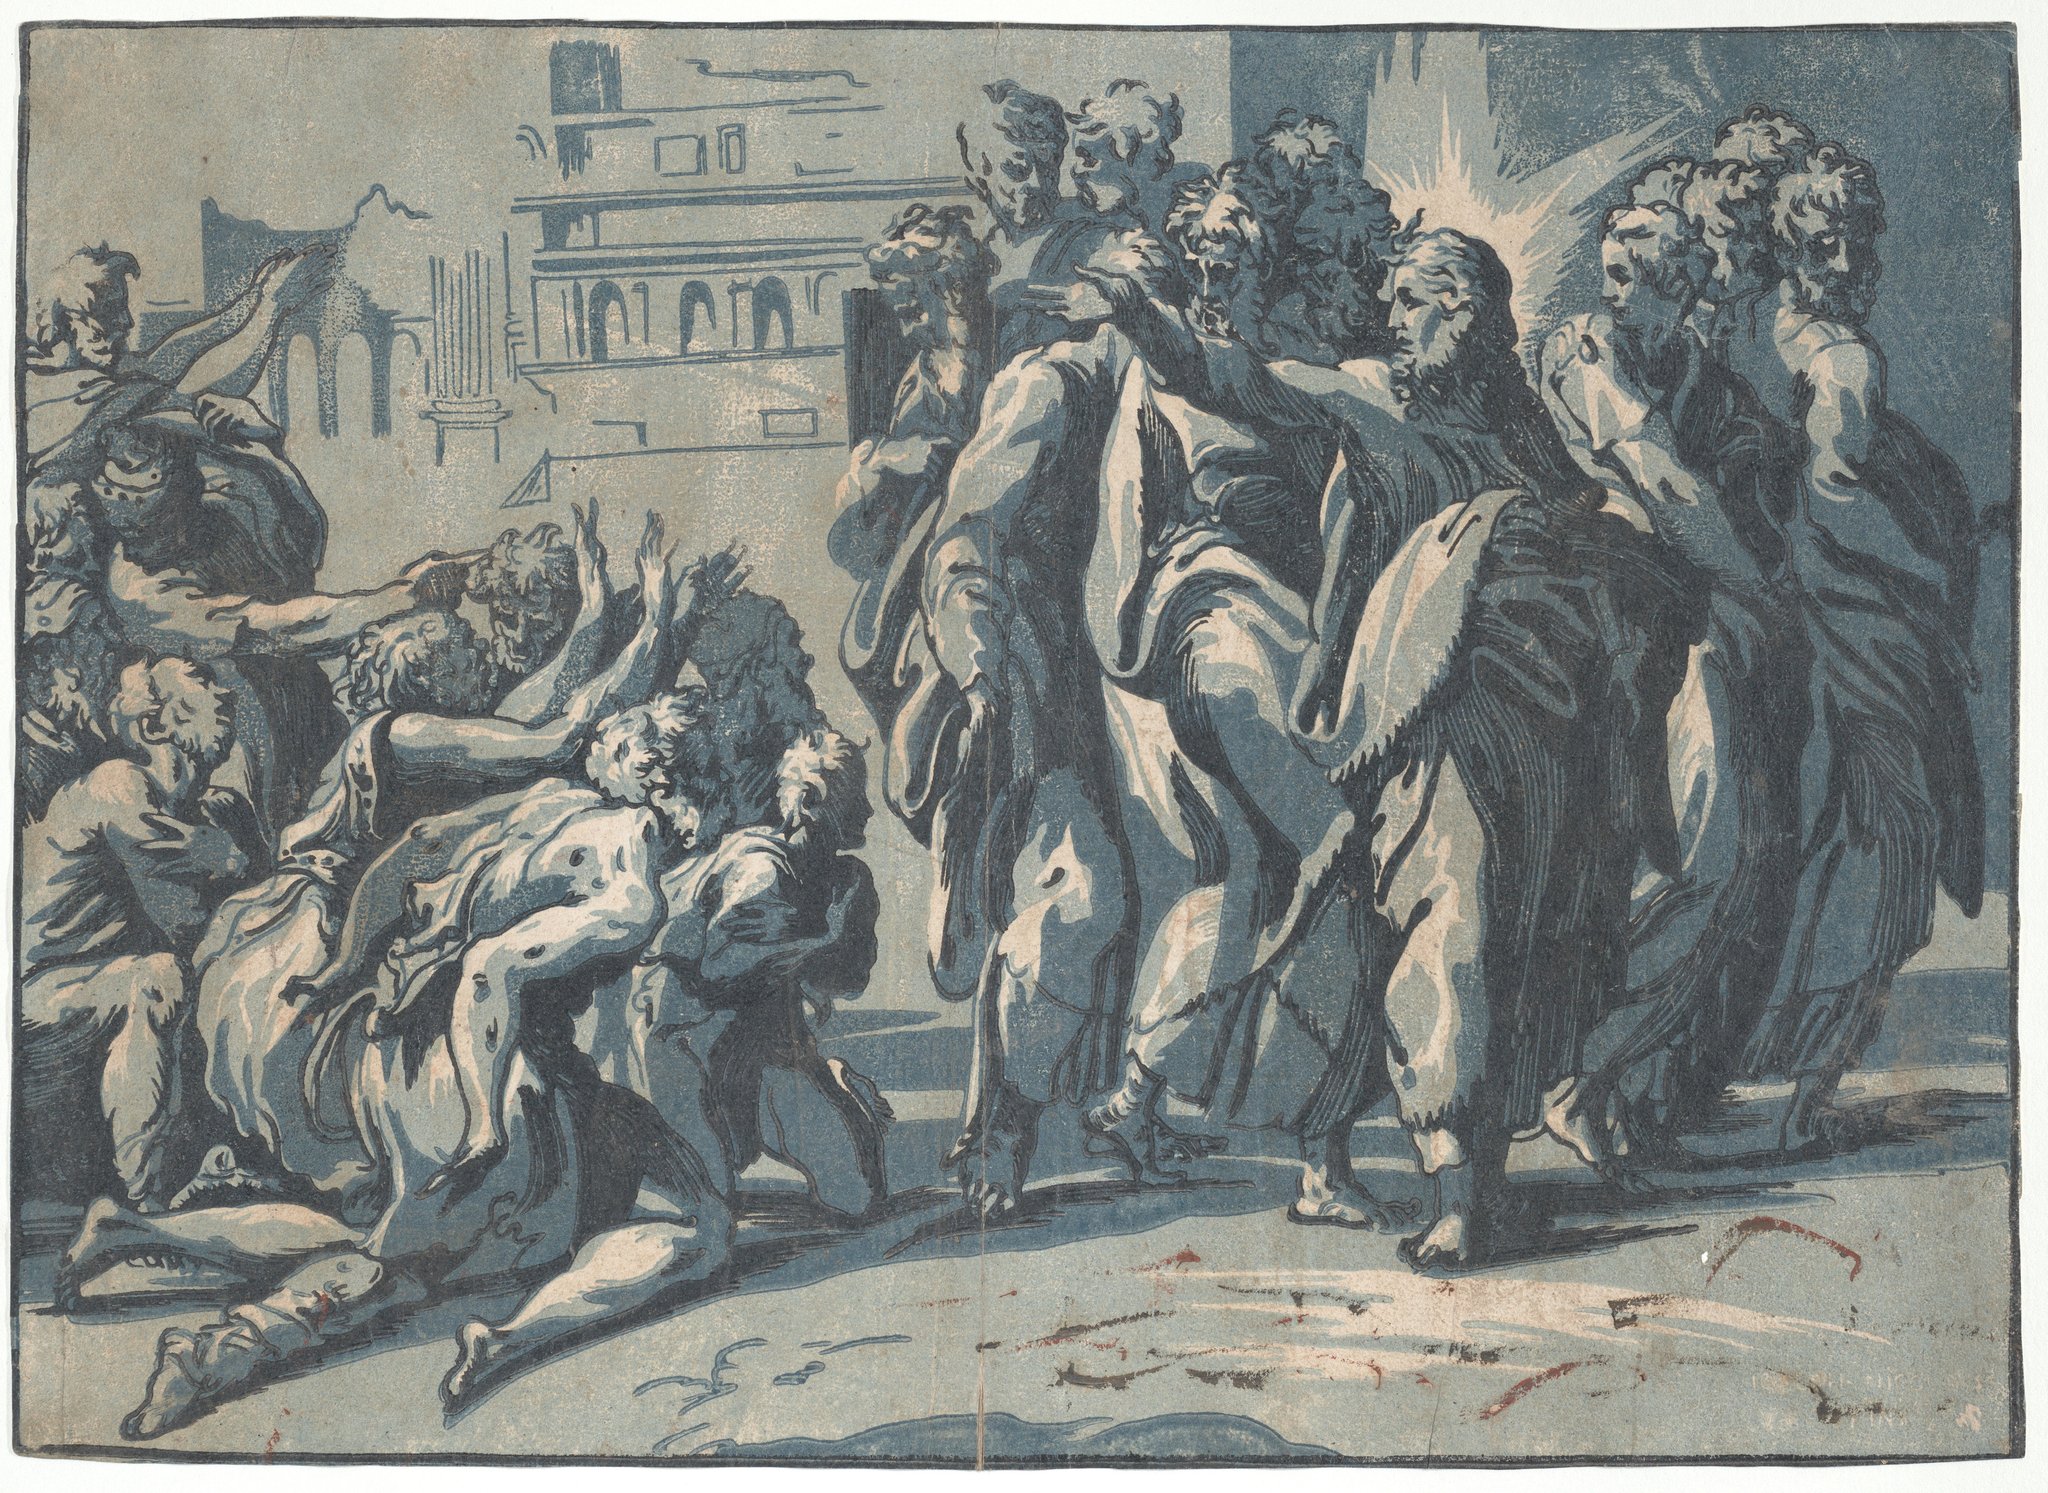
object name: print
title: Christ healing the Lepers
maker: niccolò vicentino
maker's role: artist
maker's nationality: italian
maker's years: 1510-1550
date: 1540-1550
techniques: woodcut